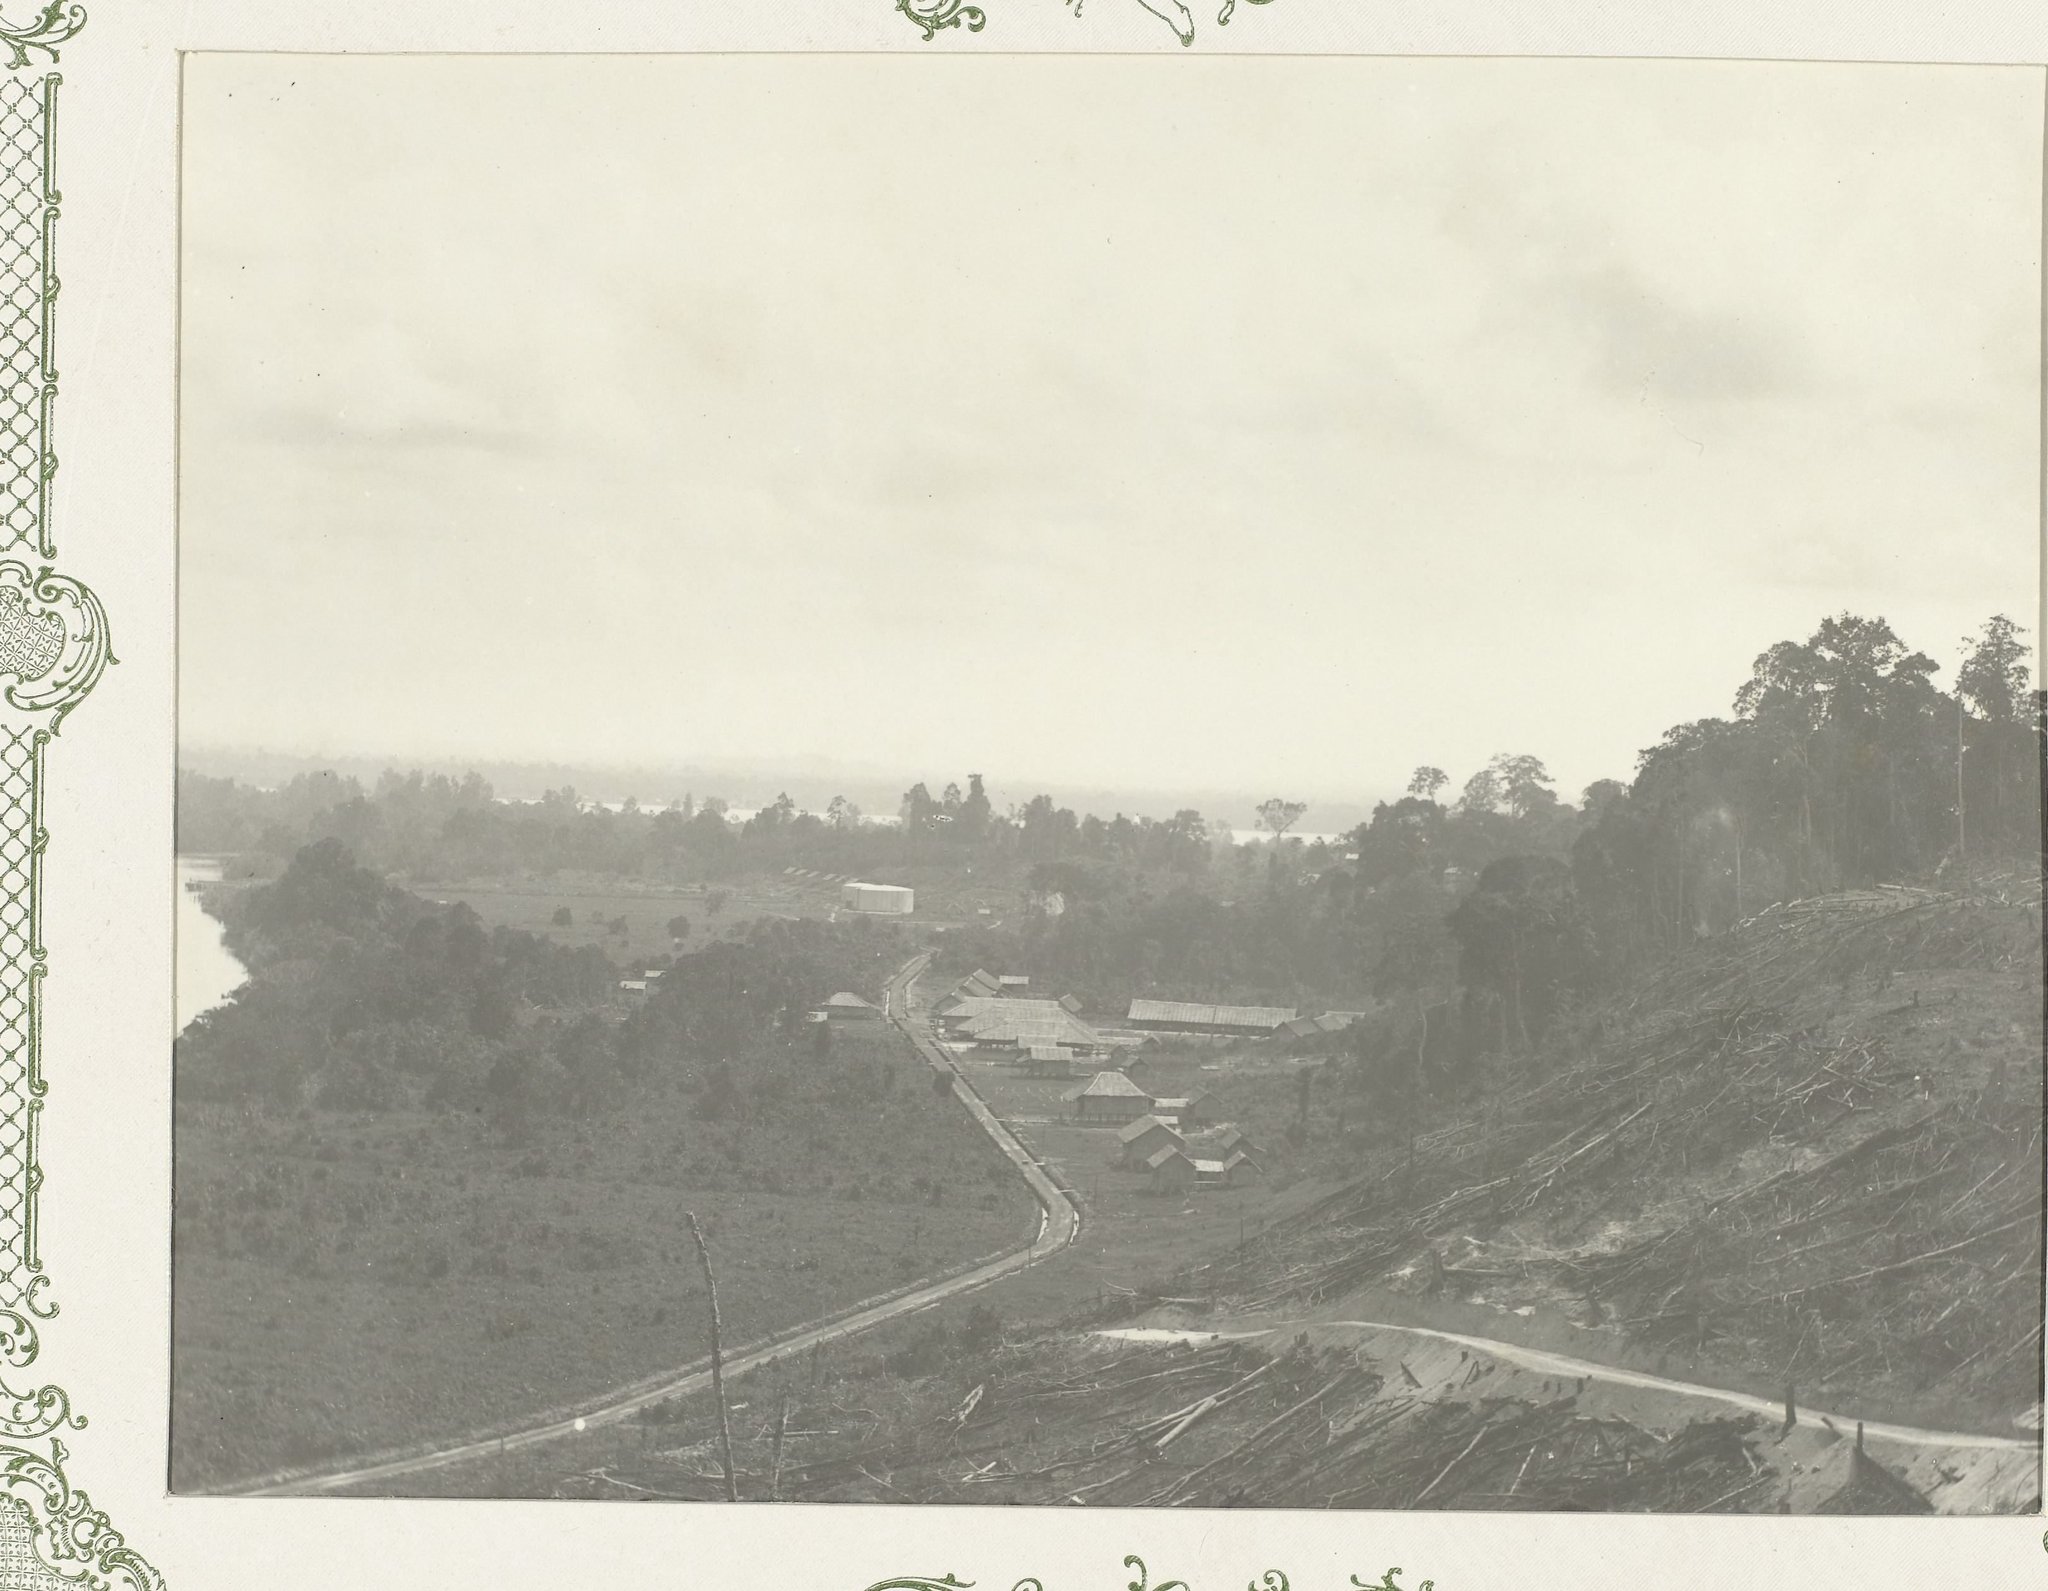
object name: photograph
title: Dorp met olietanks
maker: Anonymous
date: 1903-1907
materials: paper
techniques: gelatin silver print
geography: kalimantan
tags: oil tanks, borneo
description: Gezicht vanaf een heuvel op een dorp met olietanks, op de voorgrond terrein met gerooide bomen. Foto in het fotoalbum over de oliewinning op Borneo door de Koninklijke Nederlandsche Petroleum Maatschappij (KNPM) in de jaren 1903-1907.